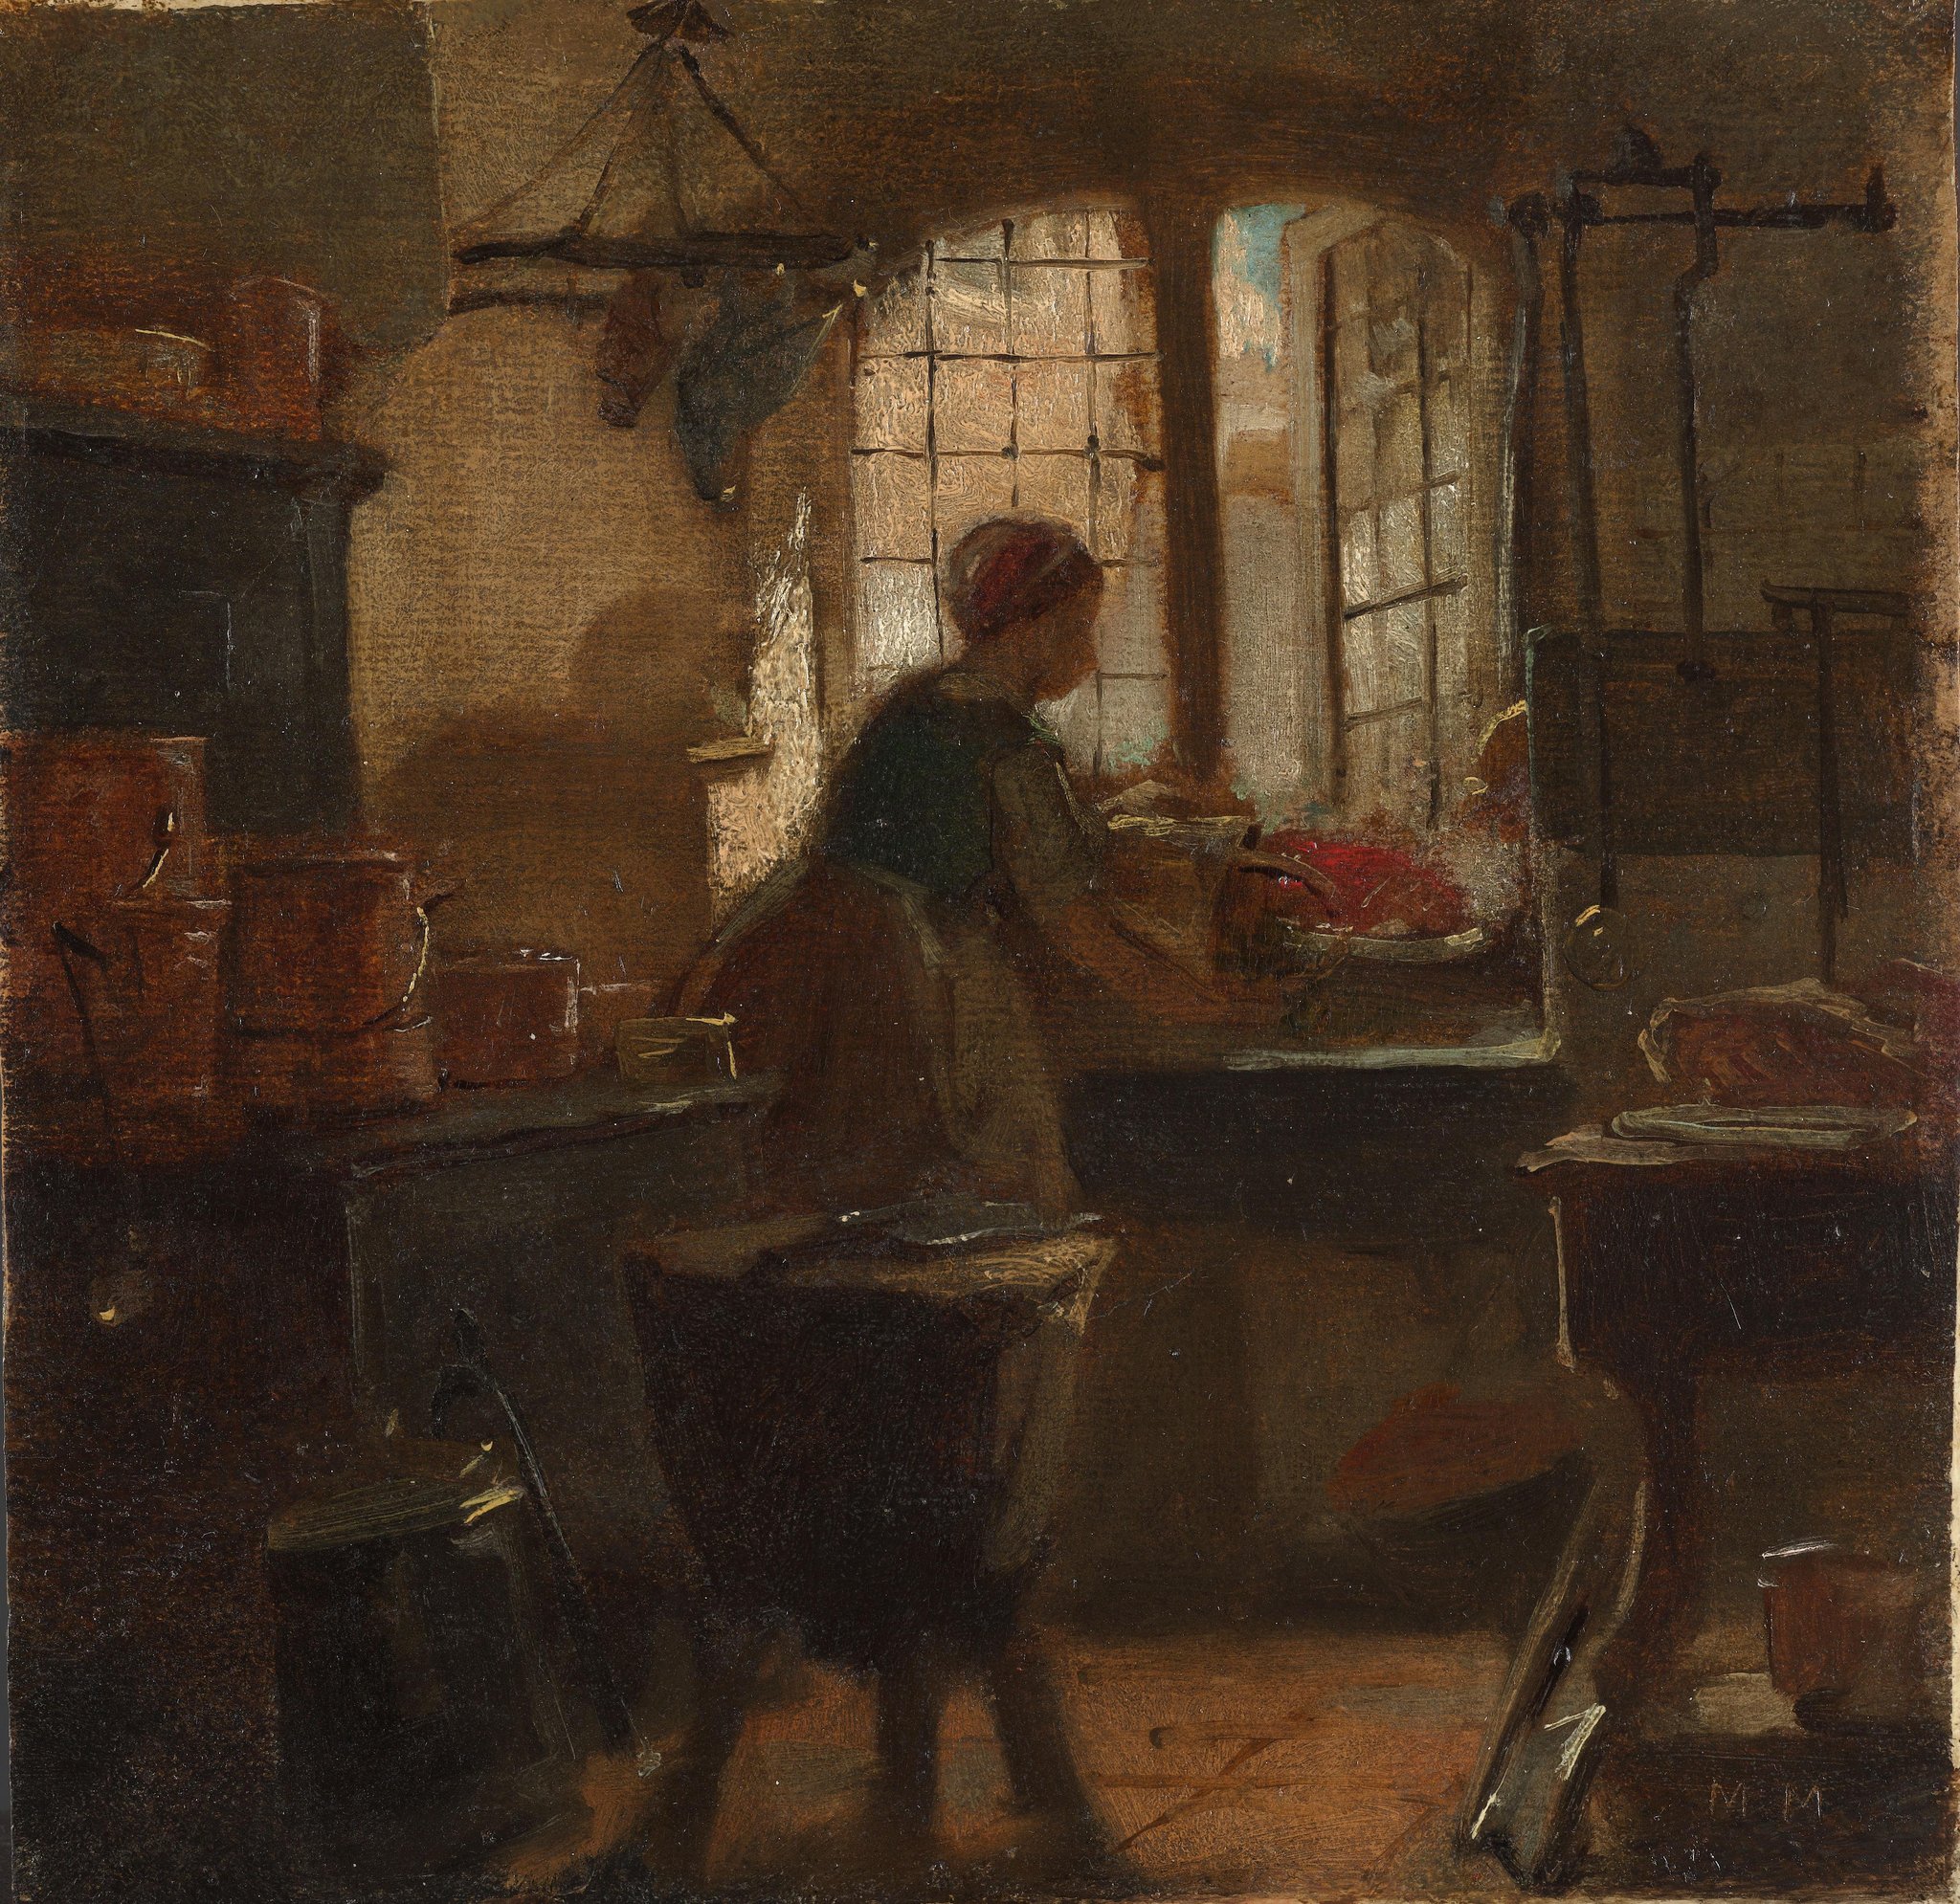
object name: painting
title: Kitchen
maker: matthijs maris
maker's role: draughtsman, painter, print maker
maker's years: 1839-1917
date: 1859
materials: oil, panel, paper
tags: kitchen-interior, kitchen-maid, kitchen servant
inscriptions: signature: ‘M.M.’, inscription: ‘Dit is van Jaap. 6 Maart 1913. M. Maris. London.’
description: Maris painted this small oil study in his Hague period, when kitchen interiors with through-views in the style of the 17th-century Dutch painter Pieter de Hooch were popular. Maris here practiced with the backlight pouring in through the window and casting the woman at the sink and the objects in the kitchen in shadow. Cleverly placed highlights give the interior greater depth and volume.